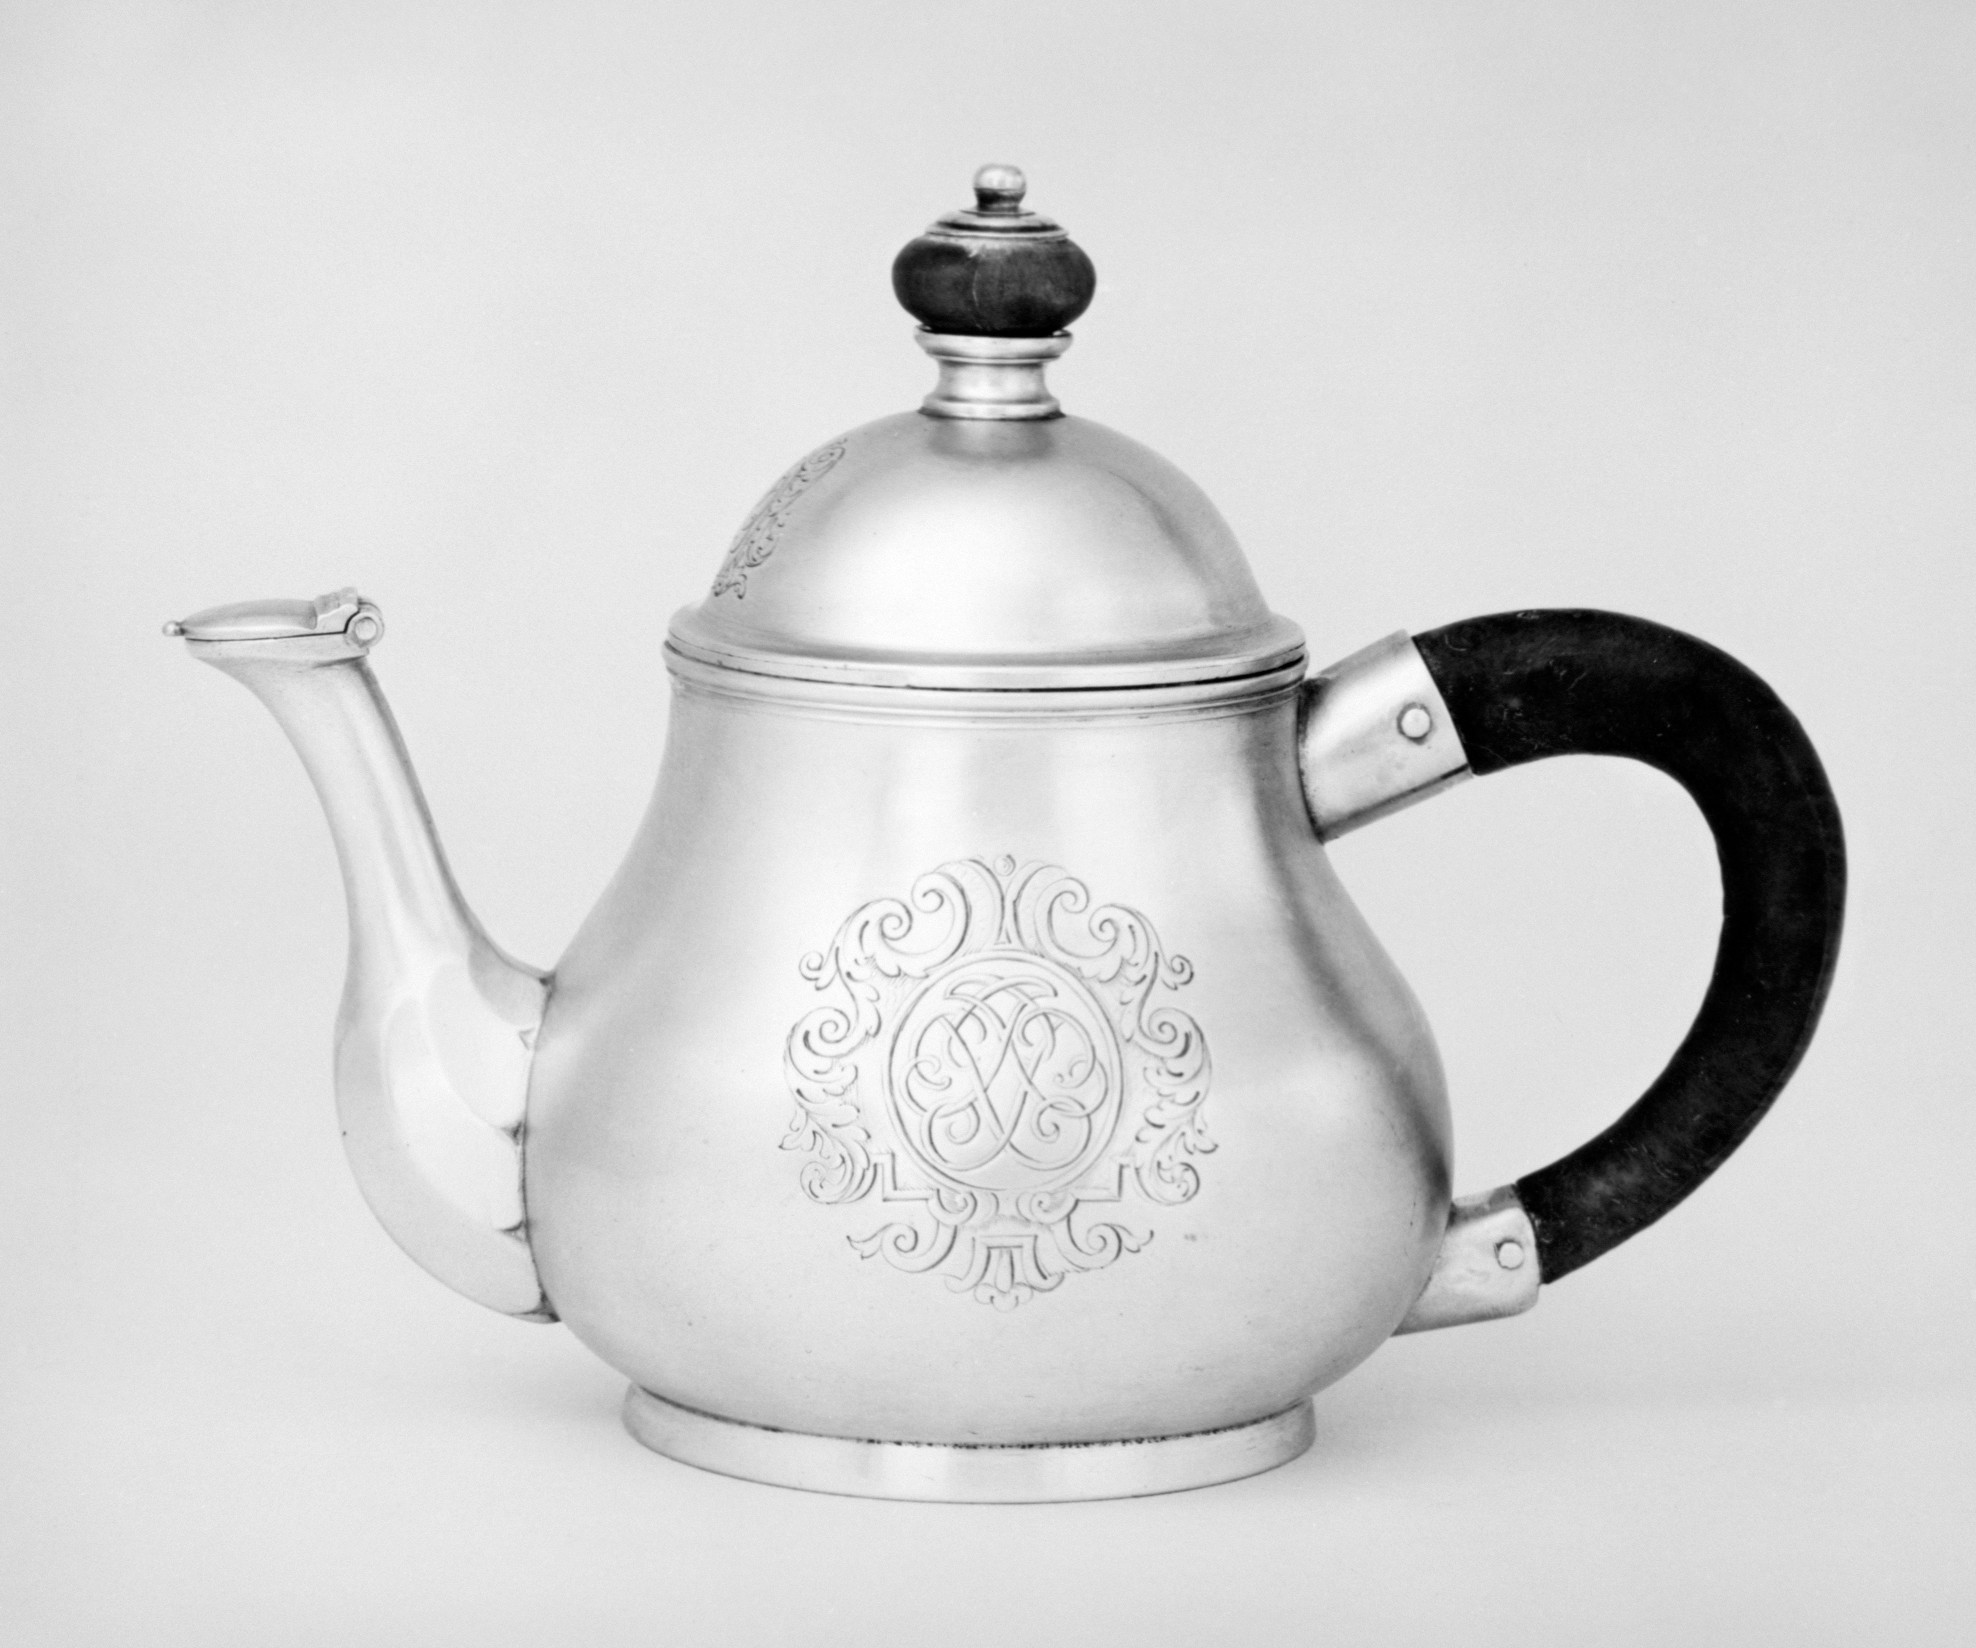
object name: teapot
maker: pierre platel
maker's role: maker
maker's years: 1699-1719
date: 1704-1705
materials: silver, wood